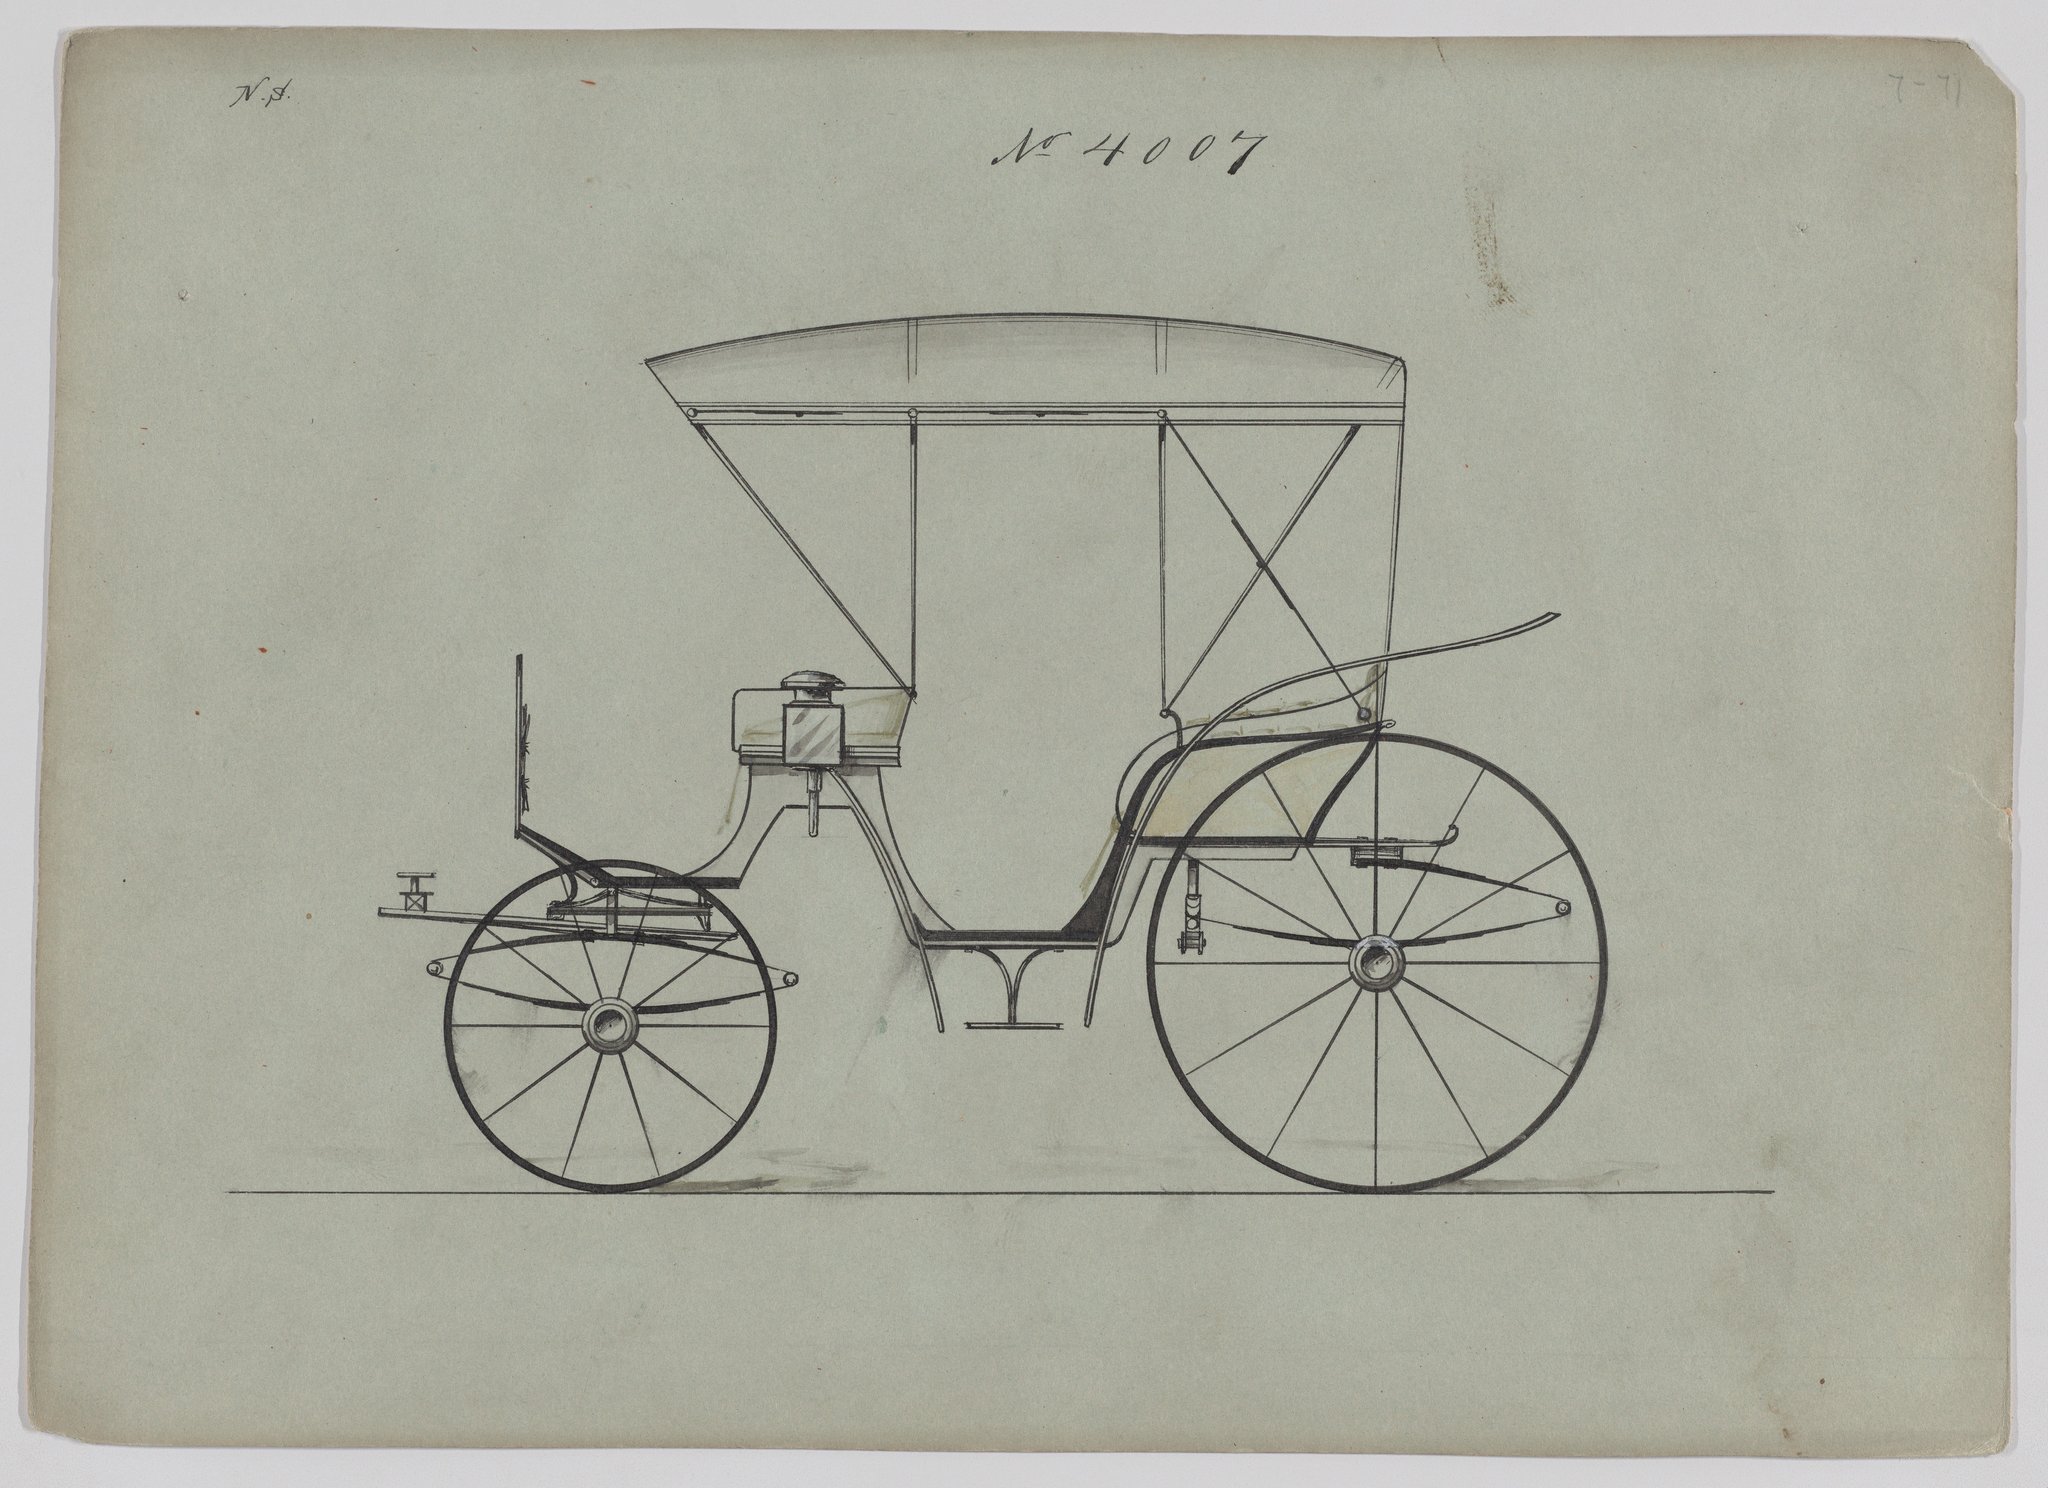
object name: drawing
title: Design for Park Phaeton, no. 4007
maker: brewster & co.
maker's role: manufacturer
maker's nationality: american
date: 1887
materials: ink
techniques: pen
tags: carriages